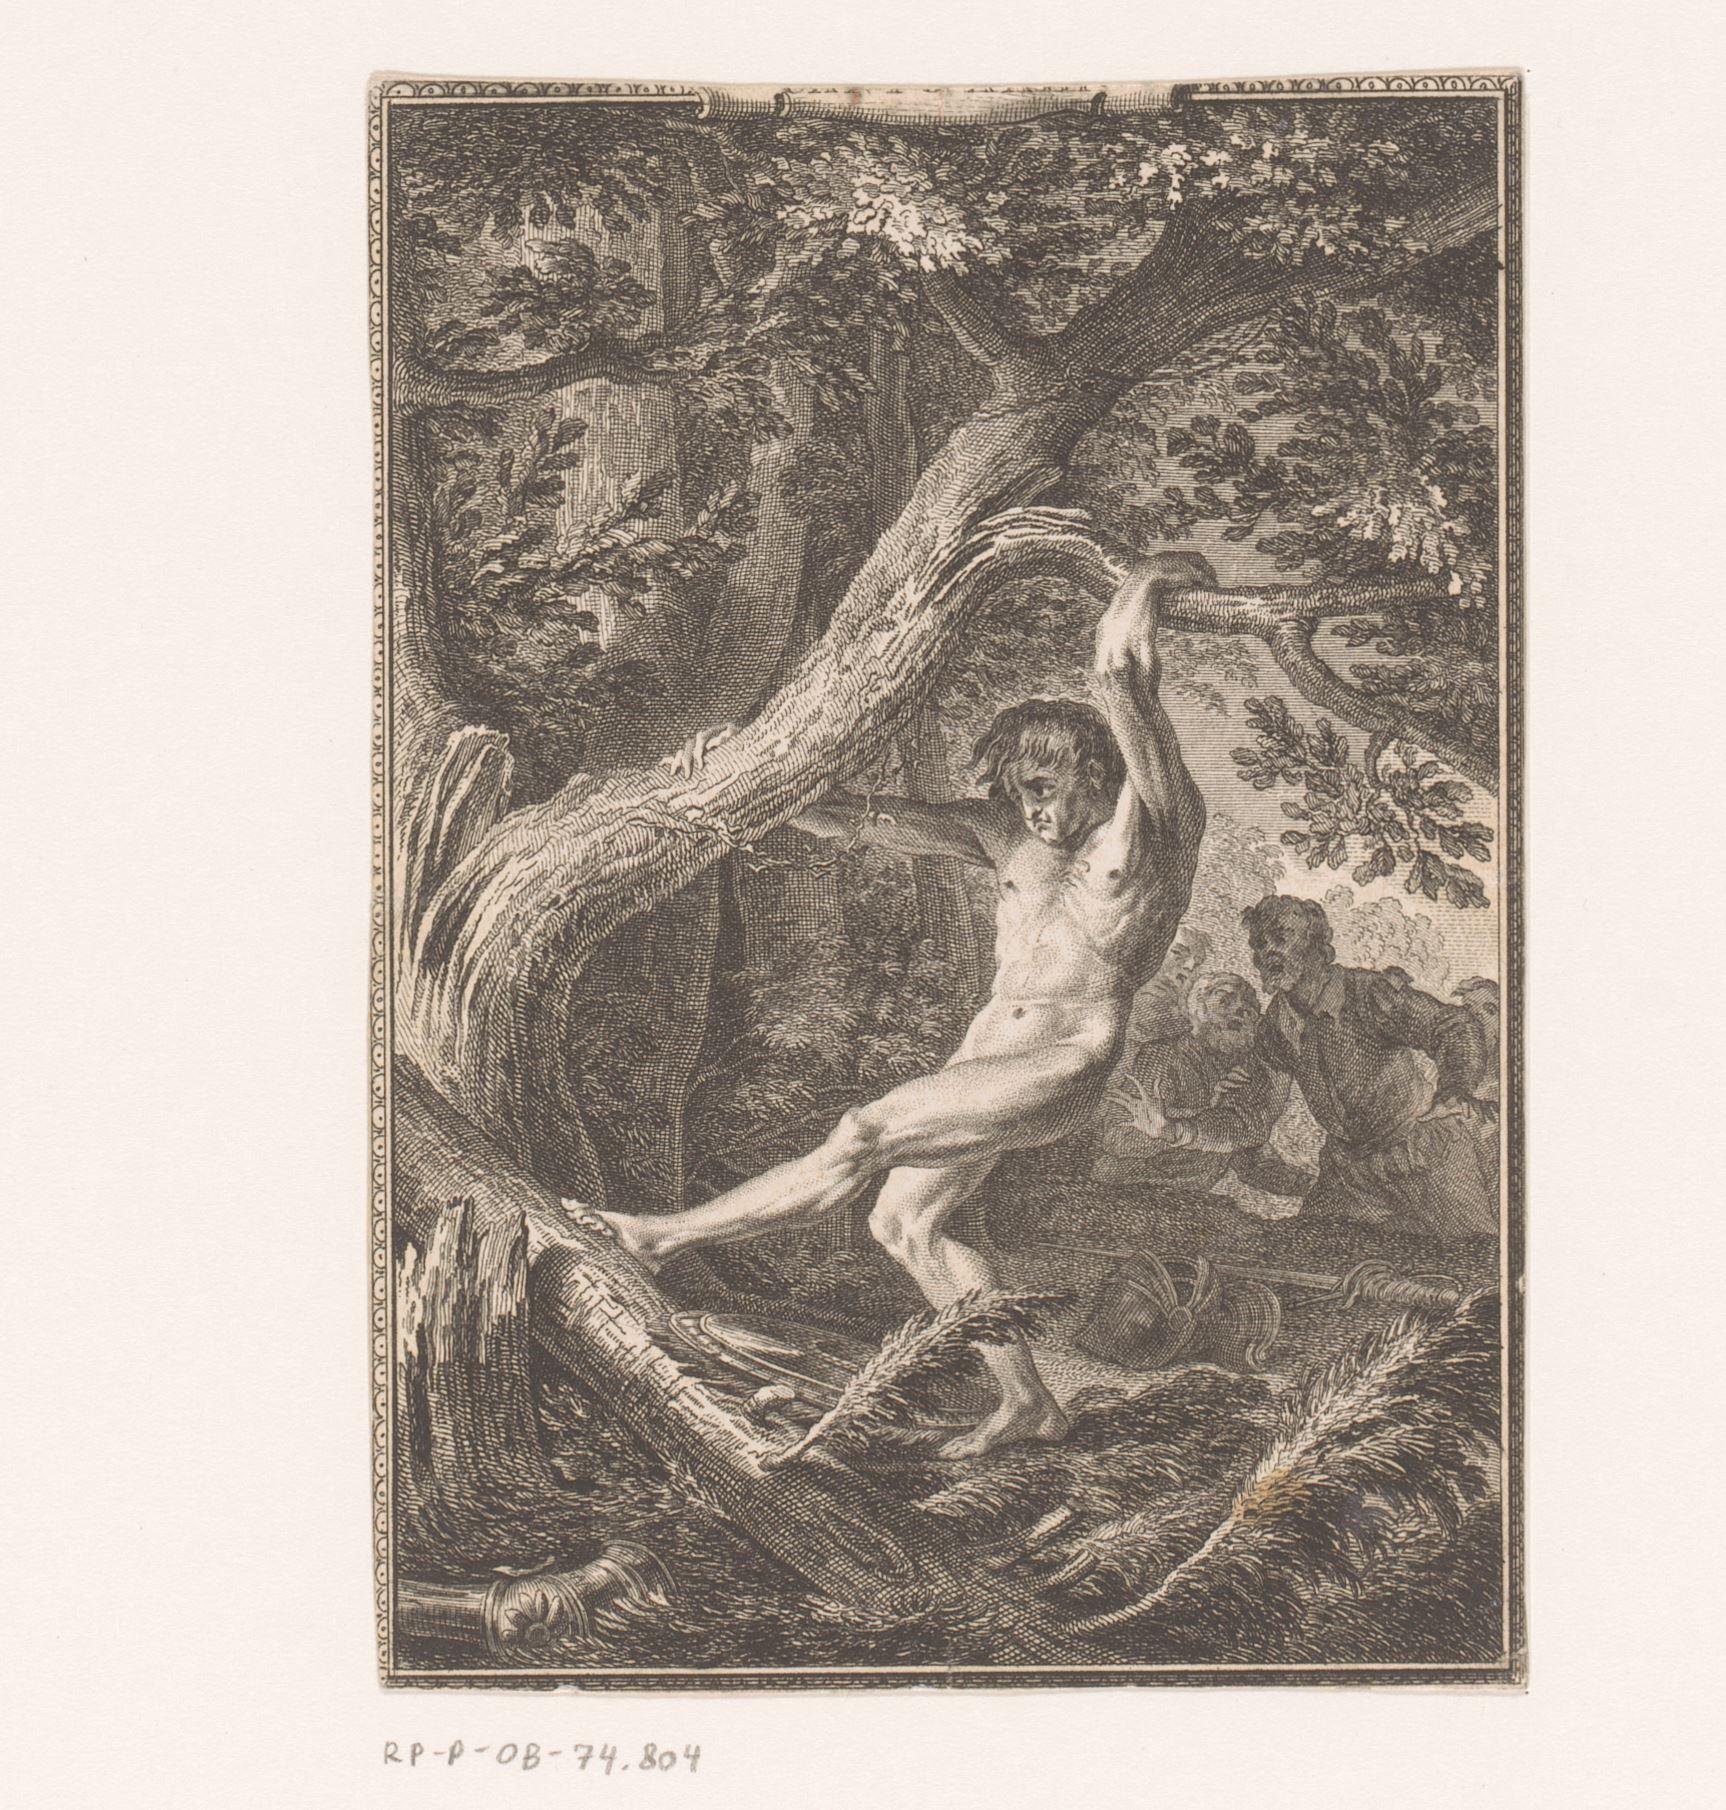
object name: print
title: Ontklede soldaat in een bos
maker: Anonymous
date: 1650-1700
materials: paper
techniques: engraving, etching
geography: france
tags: (showing oneself) undressed, quasi-nude, private soldier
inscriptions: collector's mark: Lugt 240, inscription: ‘Marin Lessard’